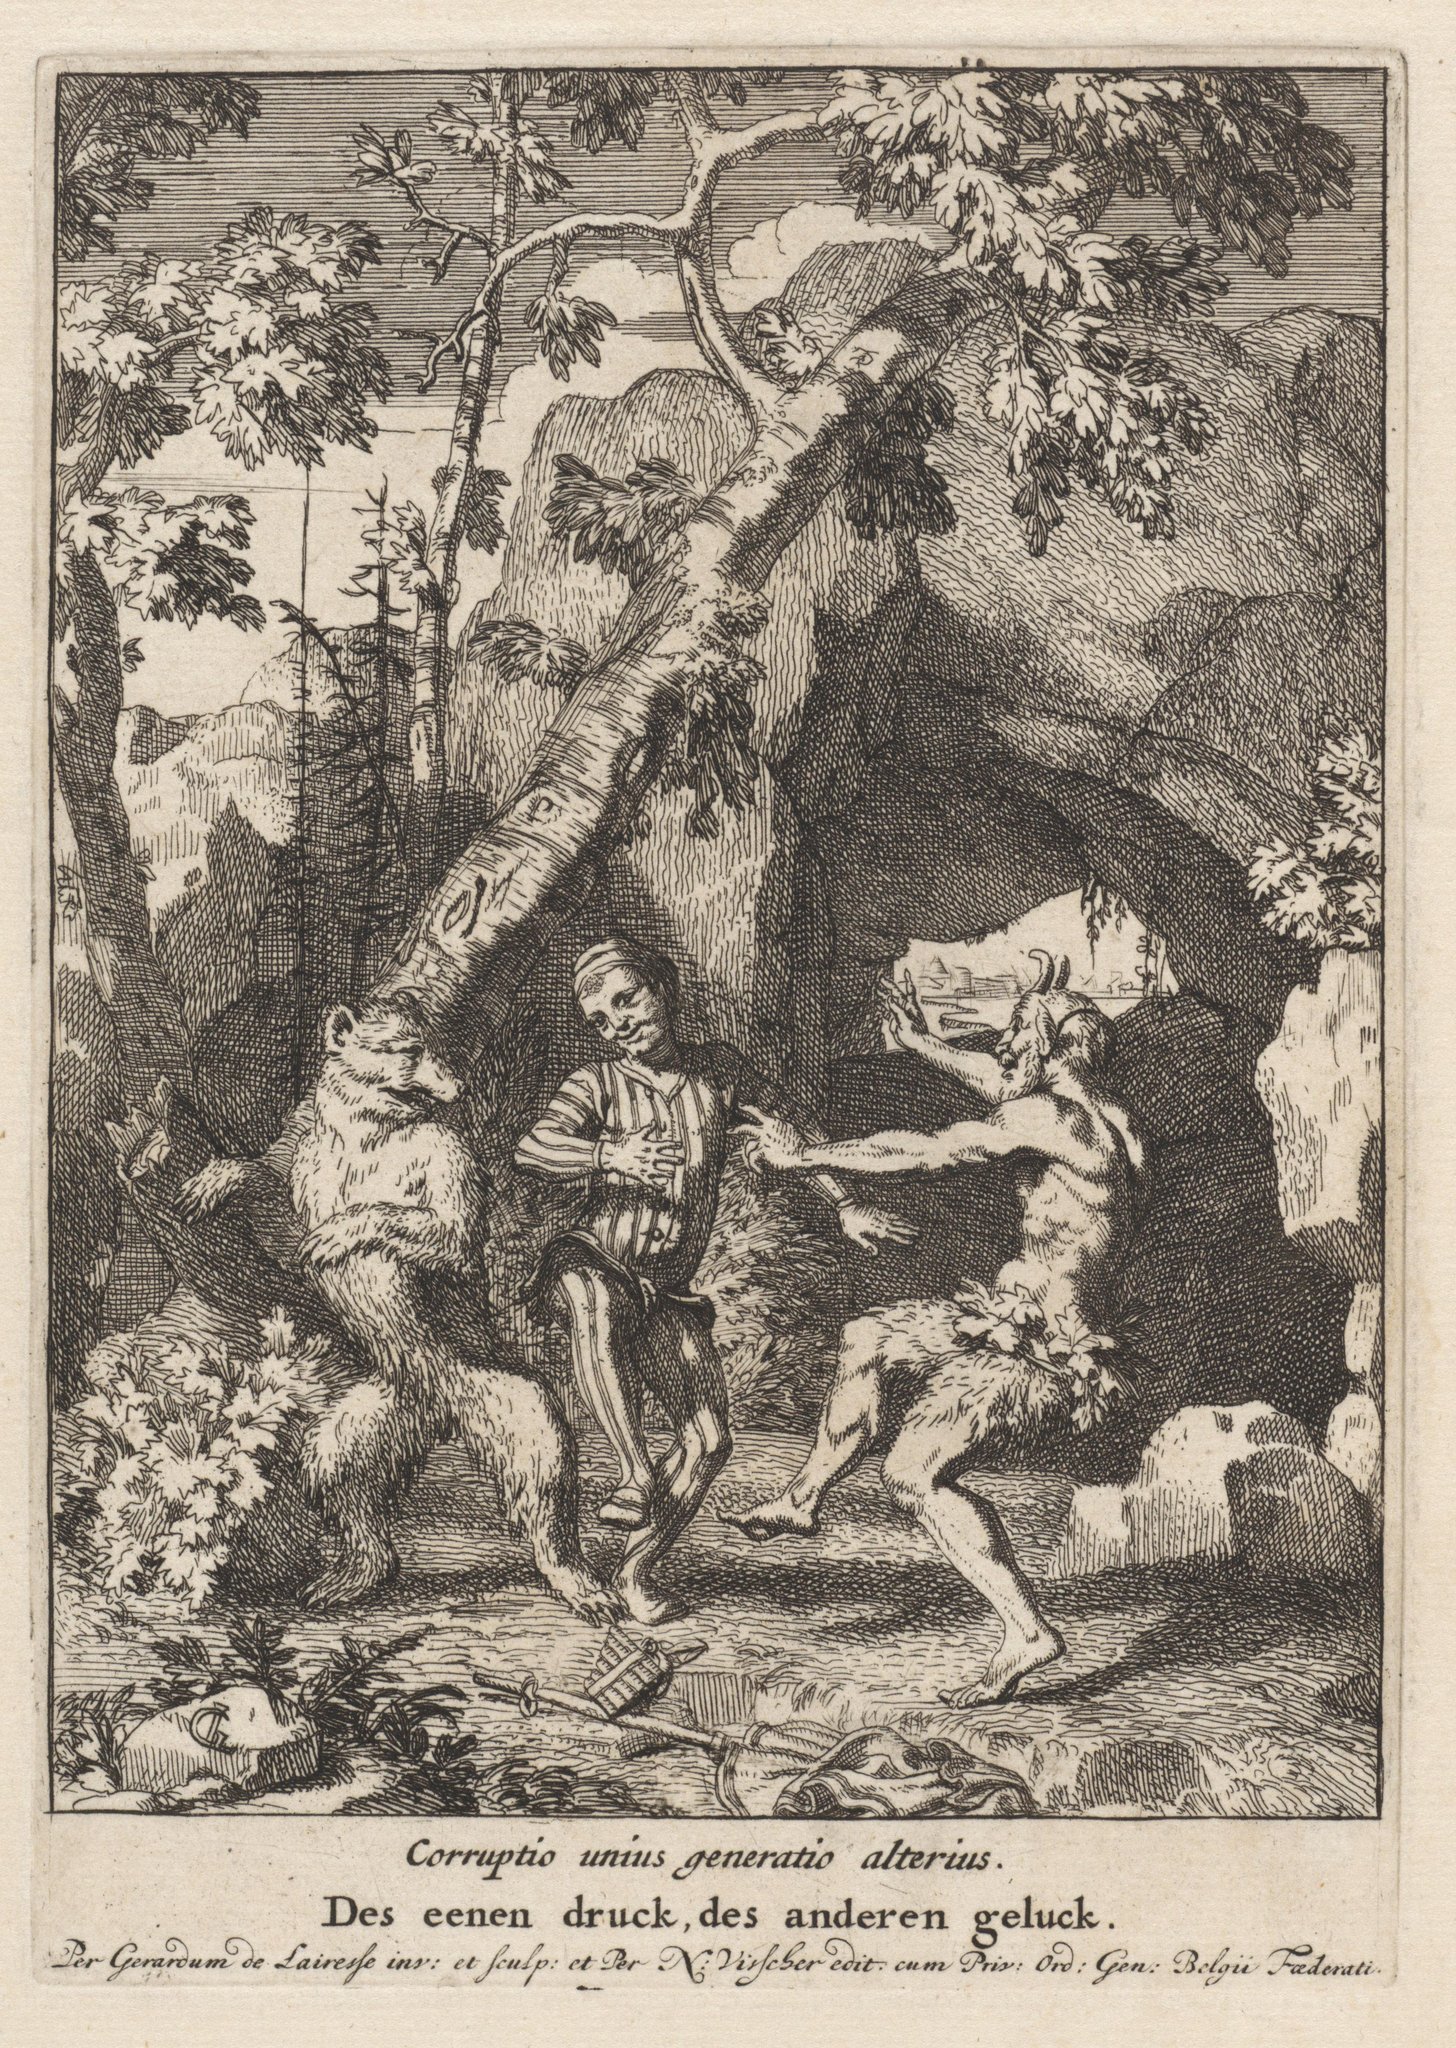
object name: print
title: Nar danst met beer en sater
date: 1668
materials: paper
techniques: etching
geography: amsterdam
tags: court jester, court fool, dancing, beasts of prey, predatory animals: bear, satyr(s) (in general)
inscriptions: collector's mark: Lugt 2228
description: Prent opgenomen in: Lairesse, Gerard. Opus elegantissimum. Amsterdam: Nicolaes Jansz. (jr.) Visscher, 1694. Deze illustratie is oorspronkelijk vervaardigd voor: Pels, Andries. Julfus, blijspel. Amsterdam: Jacob Lescaille, 1668.